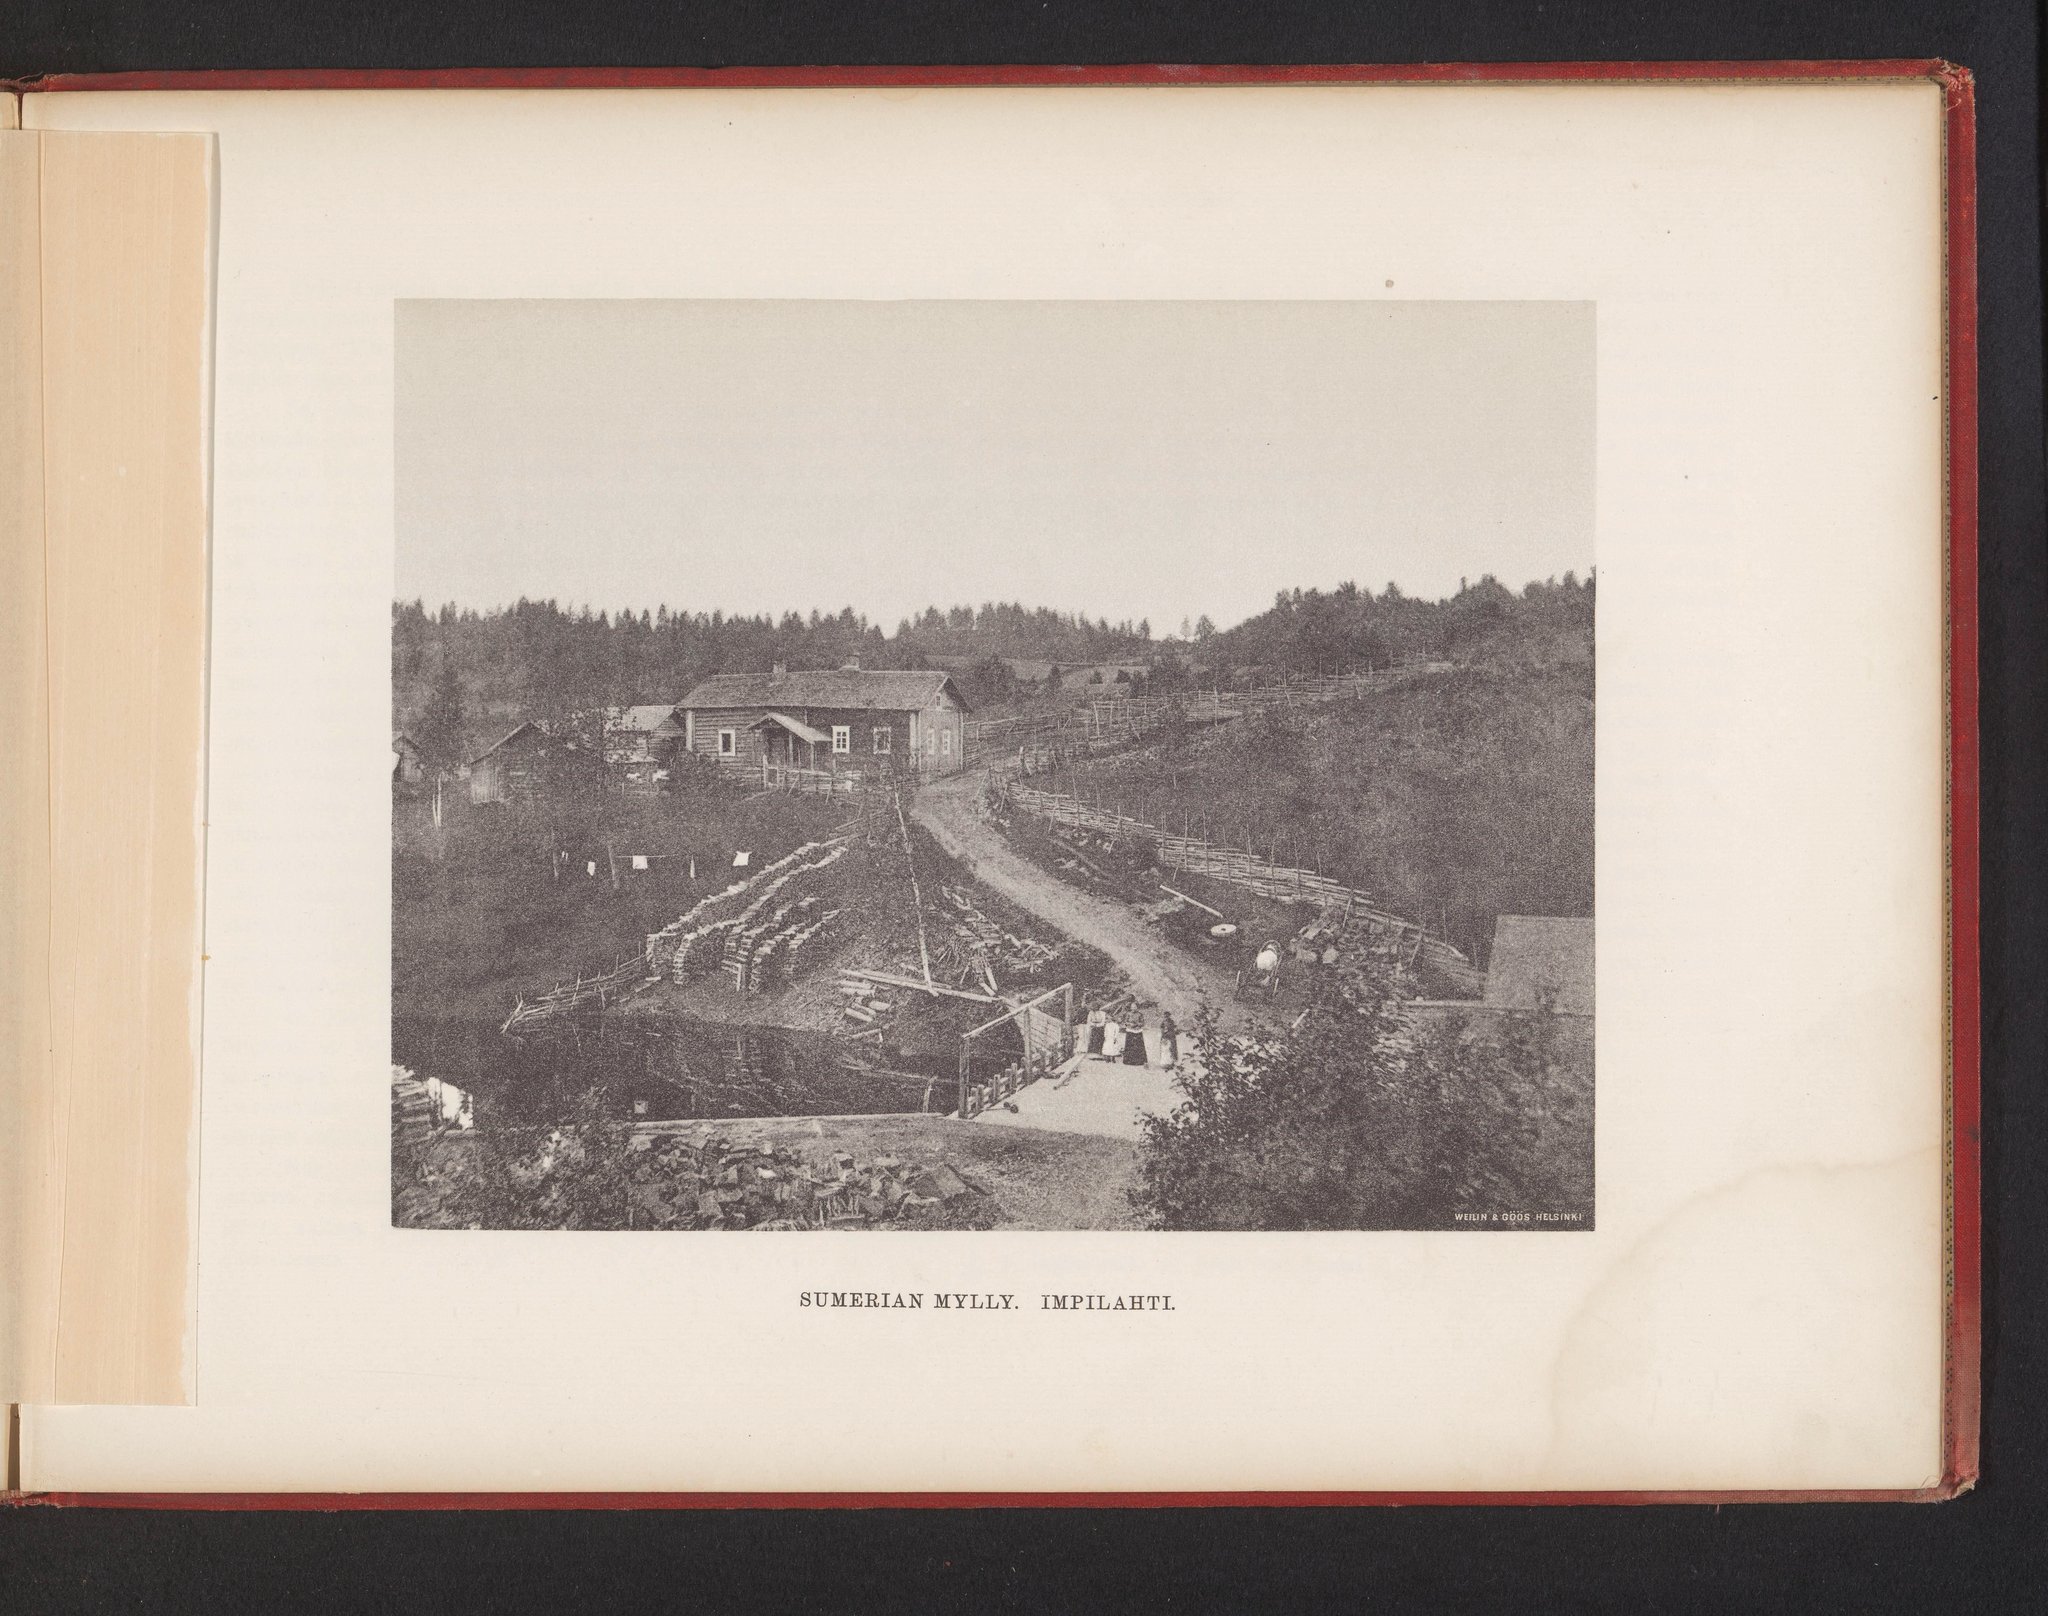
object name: page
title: Sumerian mylly. Impilahti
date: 1888-1893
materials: paper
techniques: autotype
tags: (high) hill, road, path, bridge, civic architecture; edifices; dwellings